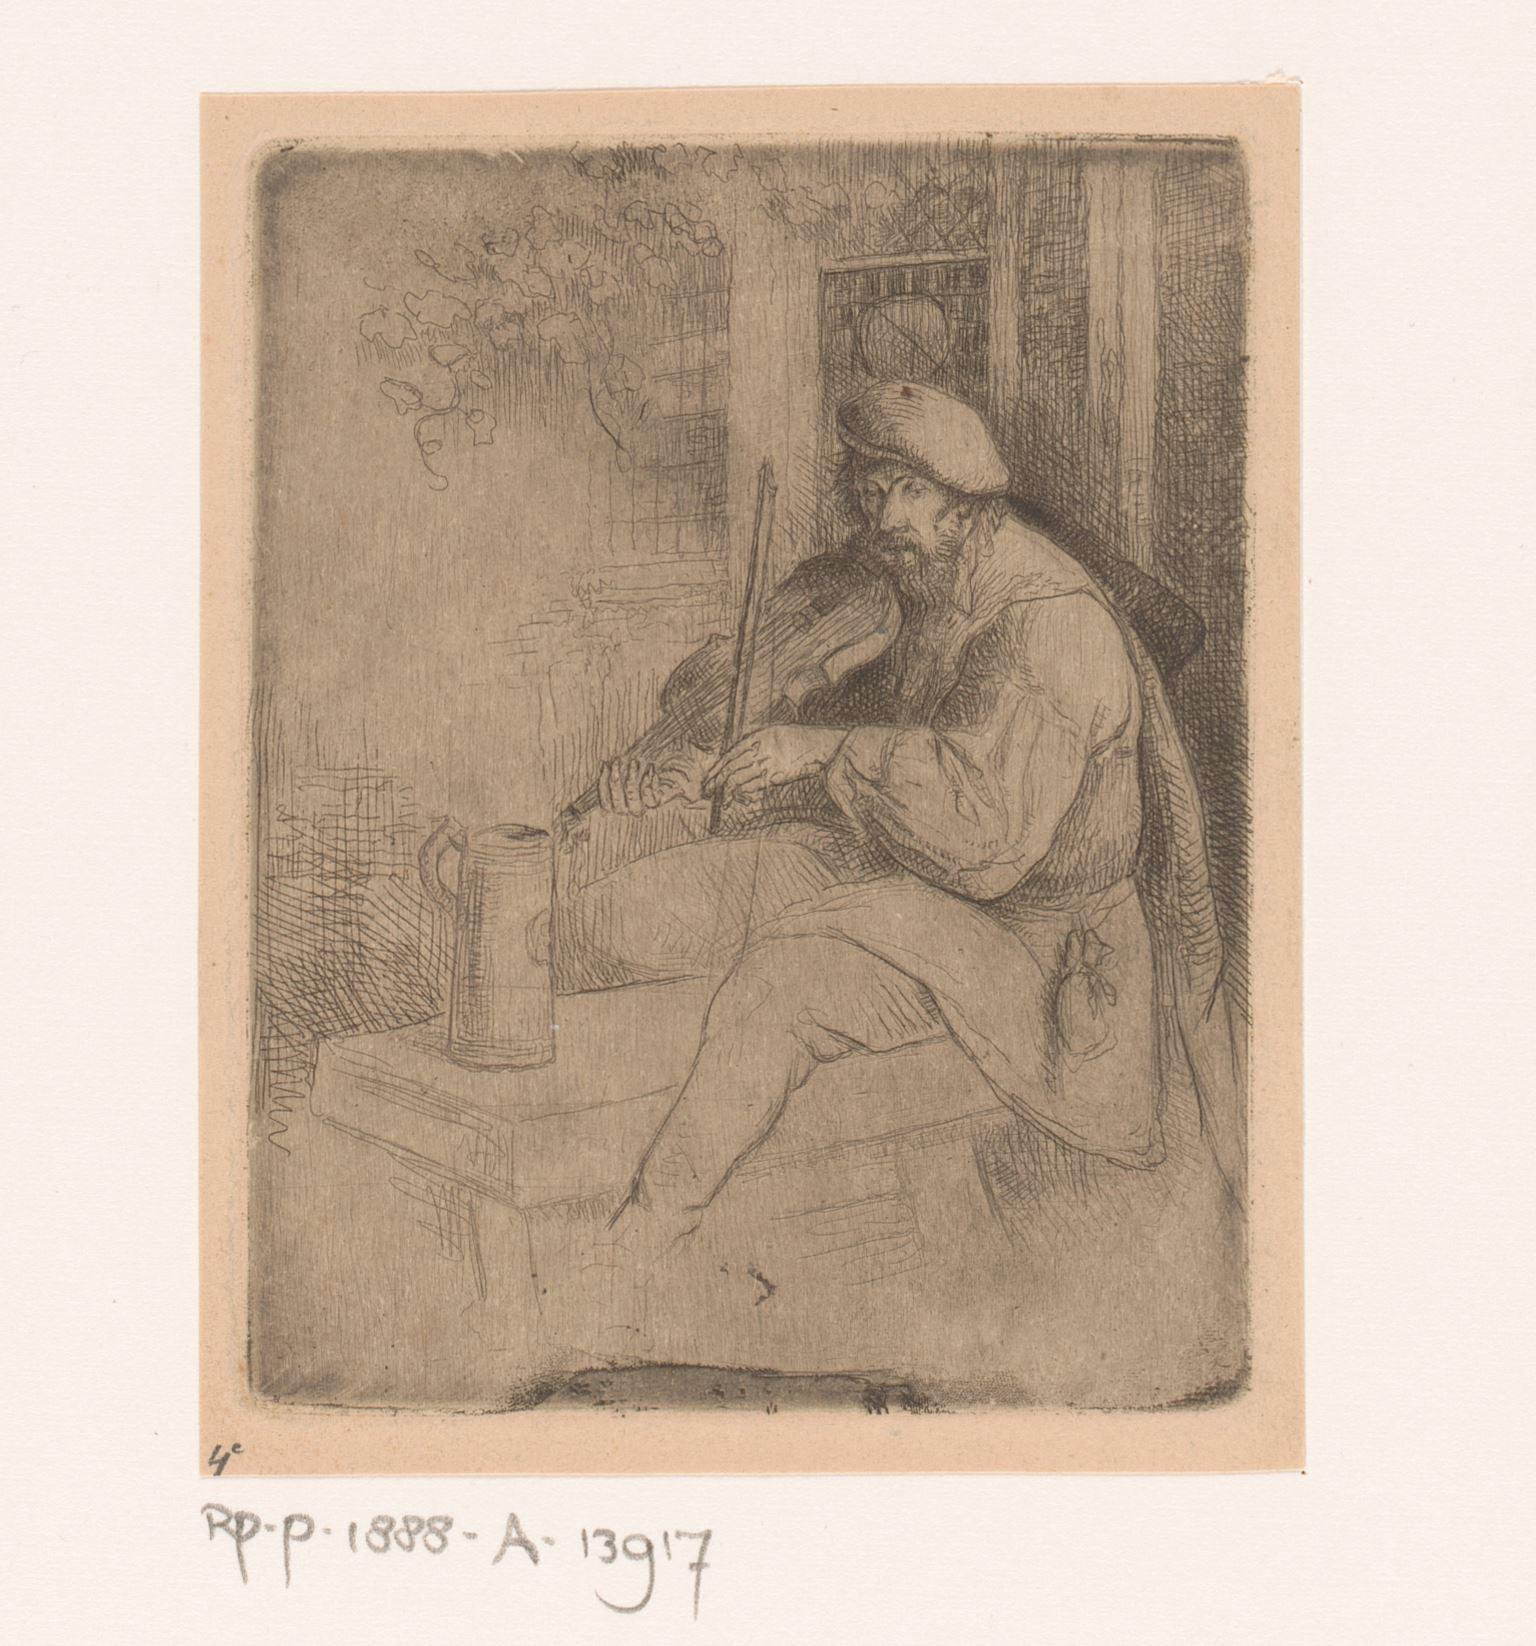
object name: print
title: Muzikant speelt viool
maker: henri leys (baron)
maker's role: draughtsman, painter, print maker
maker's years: 1815-1869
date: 1825-1869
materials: paper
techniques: drypoint, etching, intaglio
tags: minstrel, 'jongleur', violin, fiddle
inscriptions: collector's mark: Lugt 2228